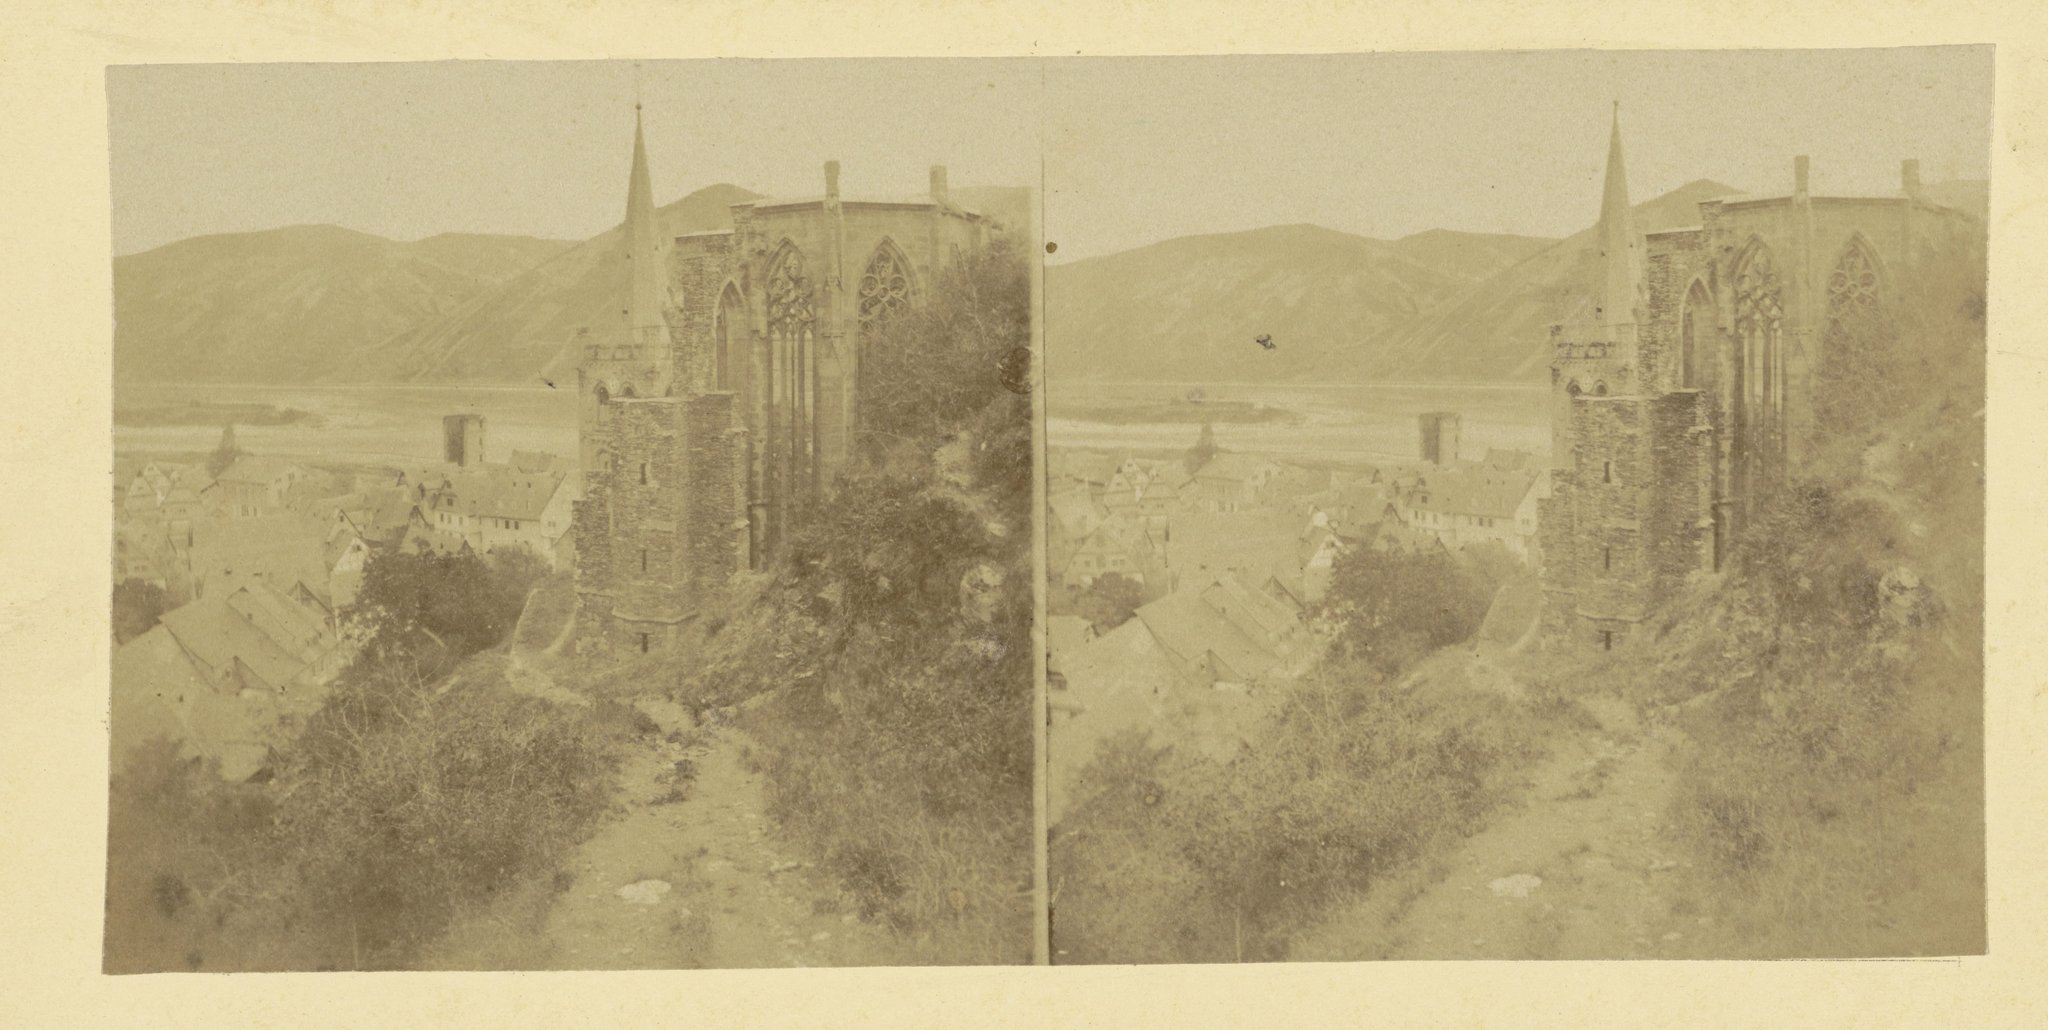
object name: stereograph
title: Ruïne van de Wernerkapel in Bacharach, Duitsland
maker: Anonymous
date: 1861-1870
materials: cardboard, paper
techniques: albumen print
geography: bacharach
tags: city-view, and landscape with man-made constructions, ruin of church, monastery, etc.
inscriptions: inscription: ‘S’, number: ‘No 89’